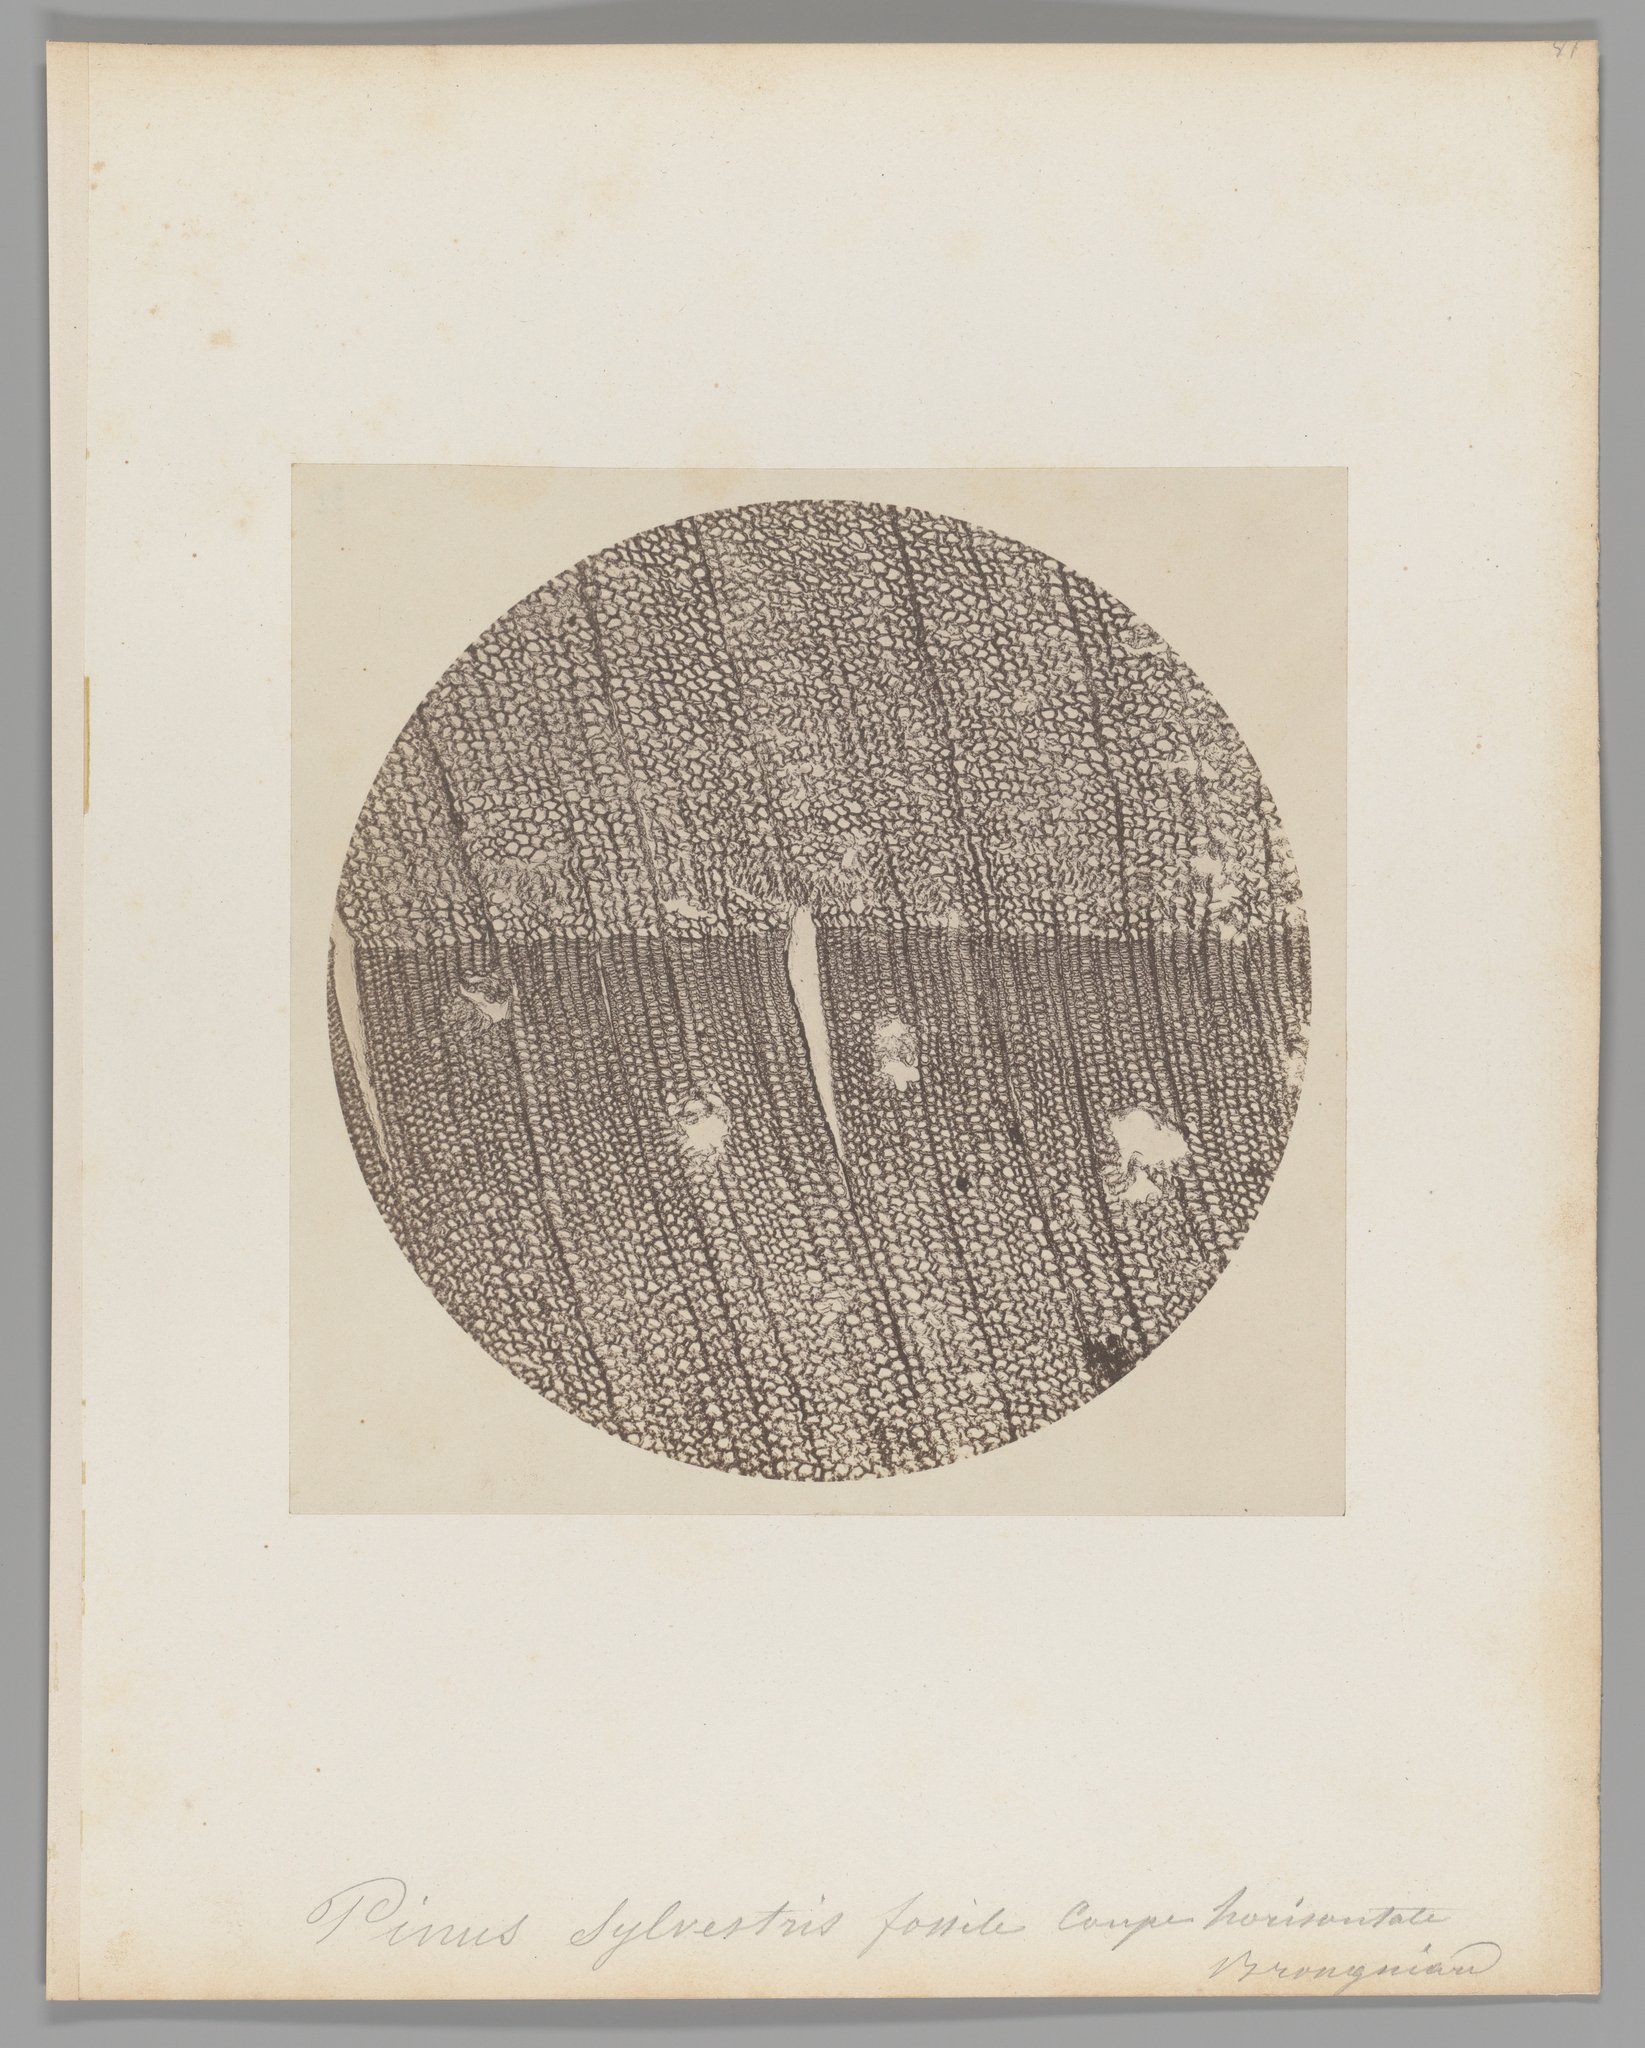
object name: photograph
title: [Untitled]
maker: auguste-adolphe bertsch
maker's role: artist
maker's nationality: french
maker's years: 1813-1871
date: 1853-1857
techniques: salted paper print